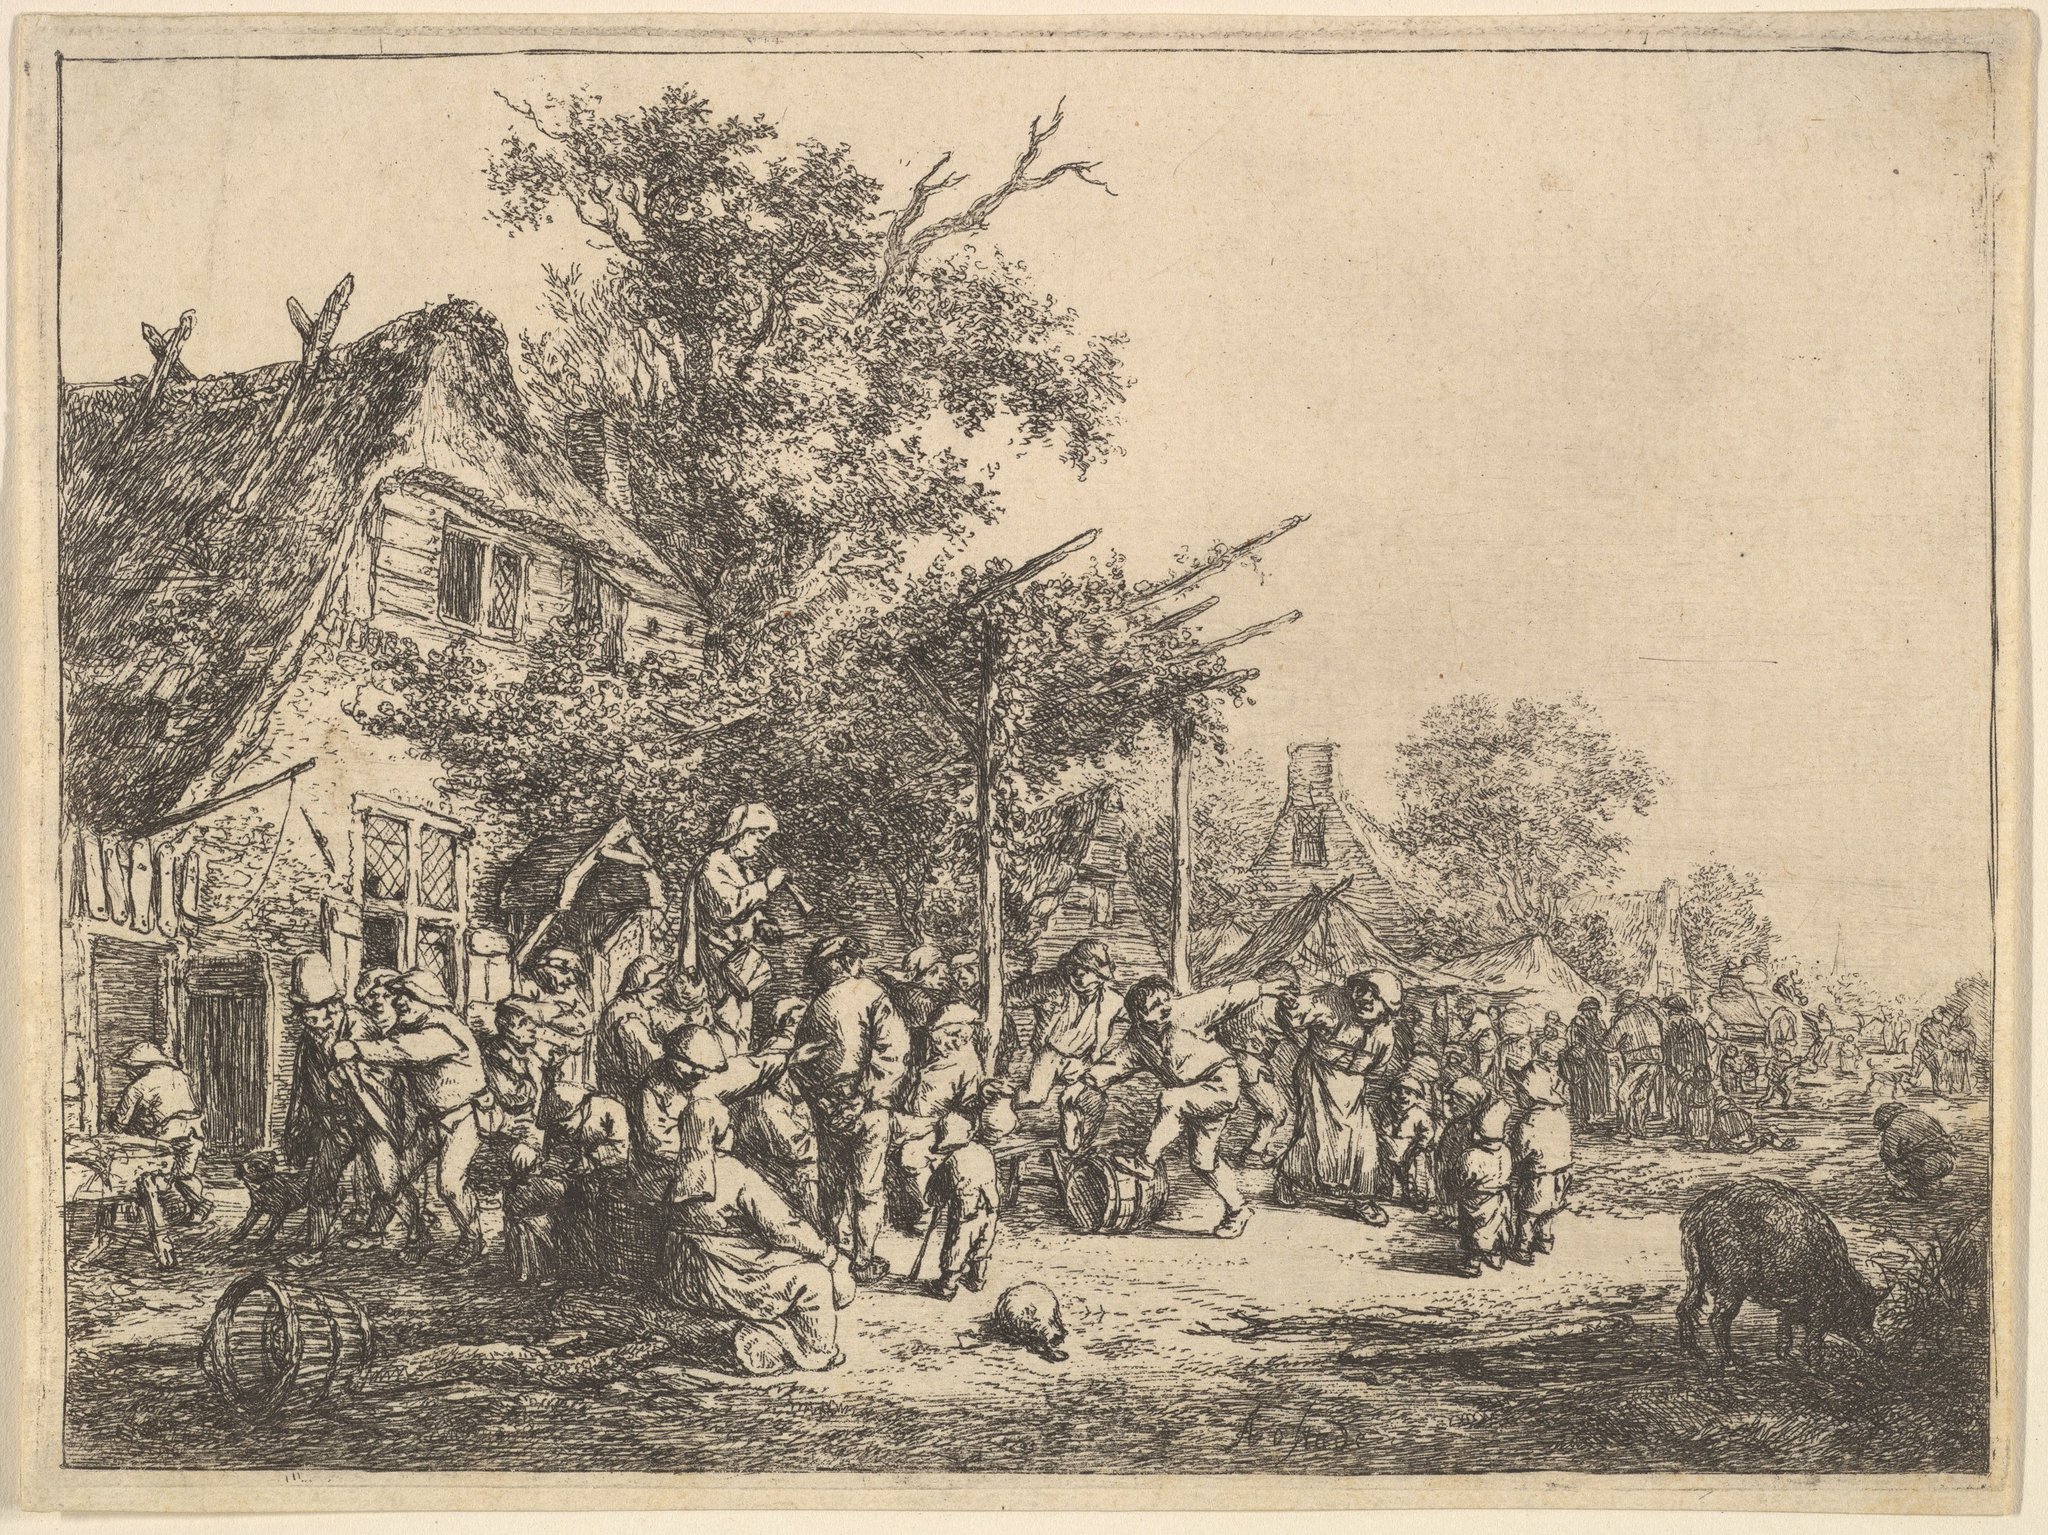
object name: print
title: Dance Under the Trellis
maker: adriaen van ostade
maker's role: artist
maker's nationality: dutch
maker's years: 1610-1685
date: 1610-1685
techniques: etching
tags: houses,children,men,women,dancing